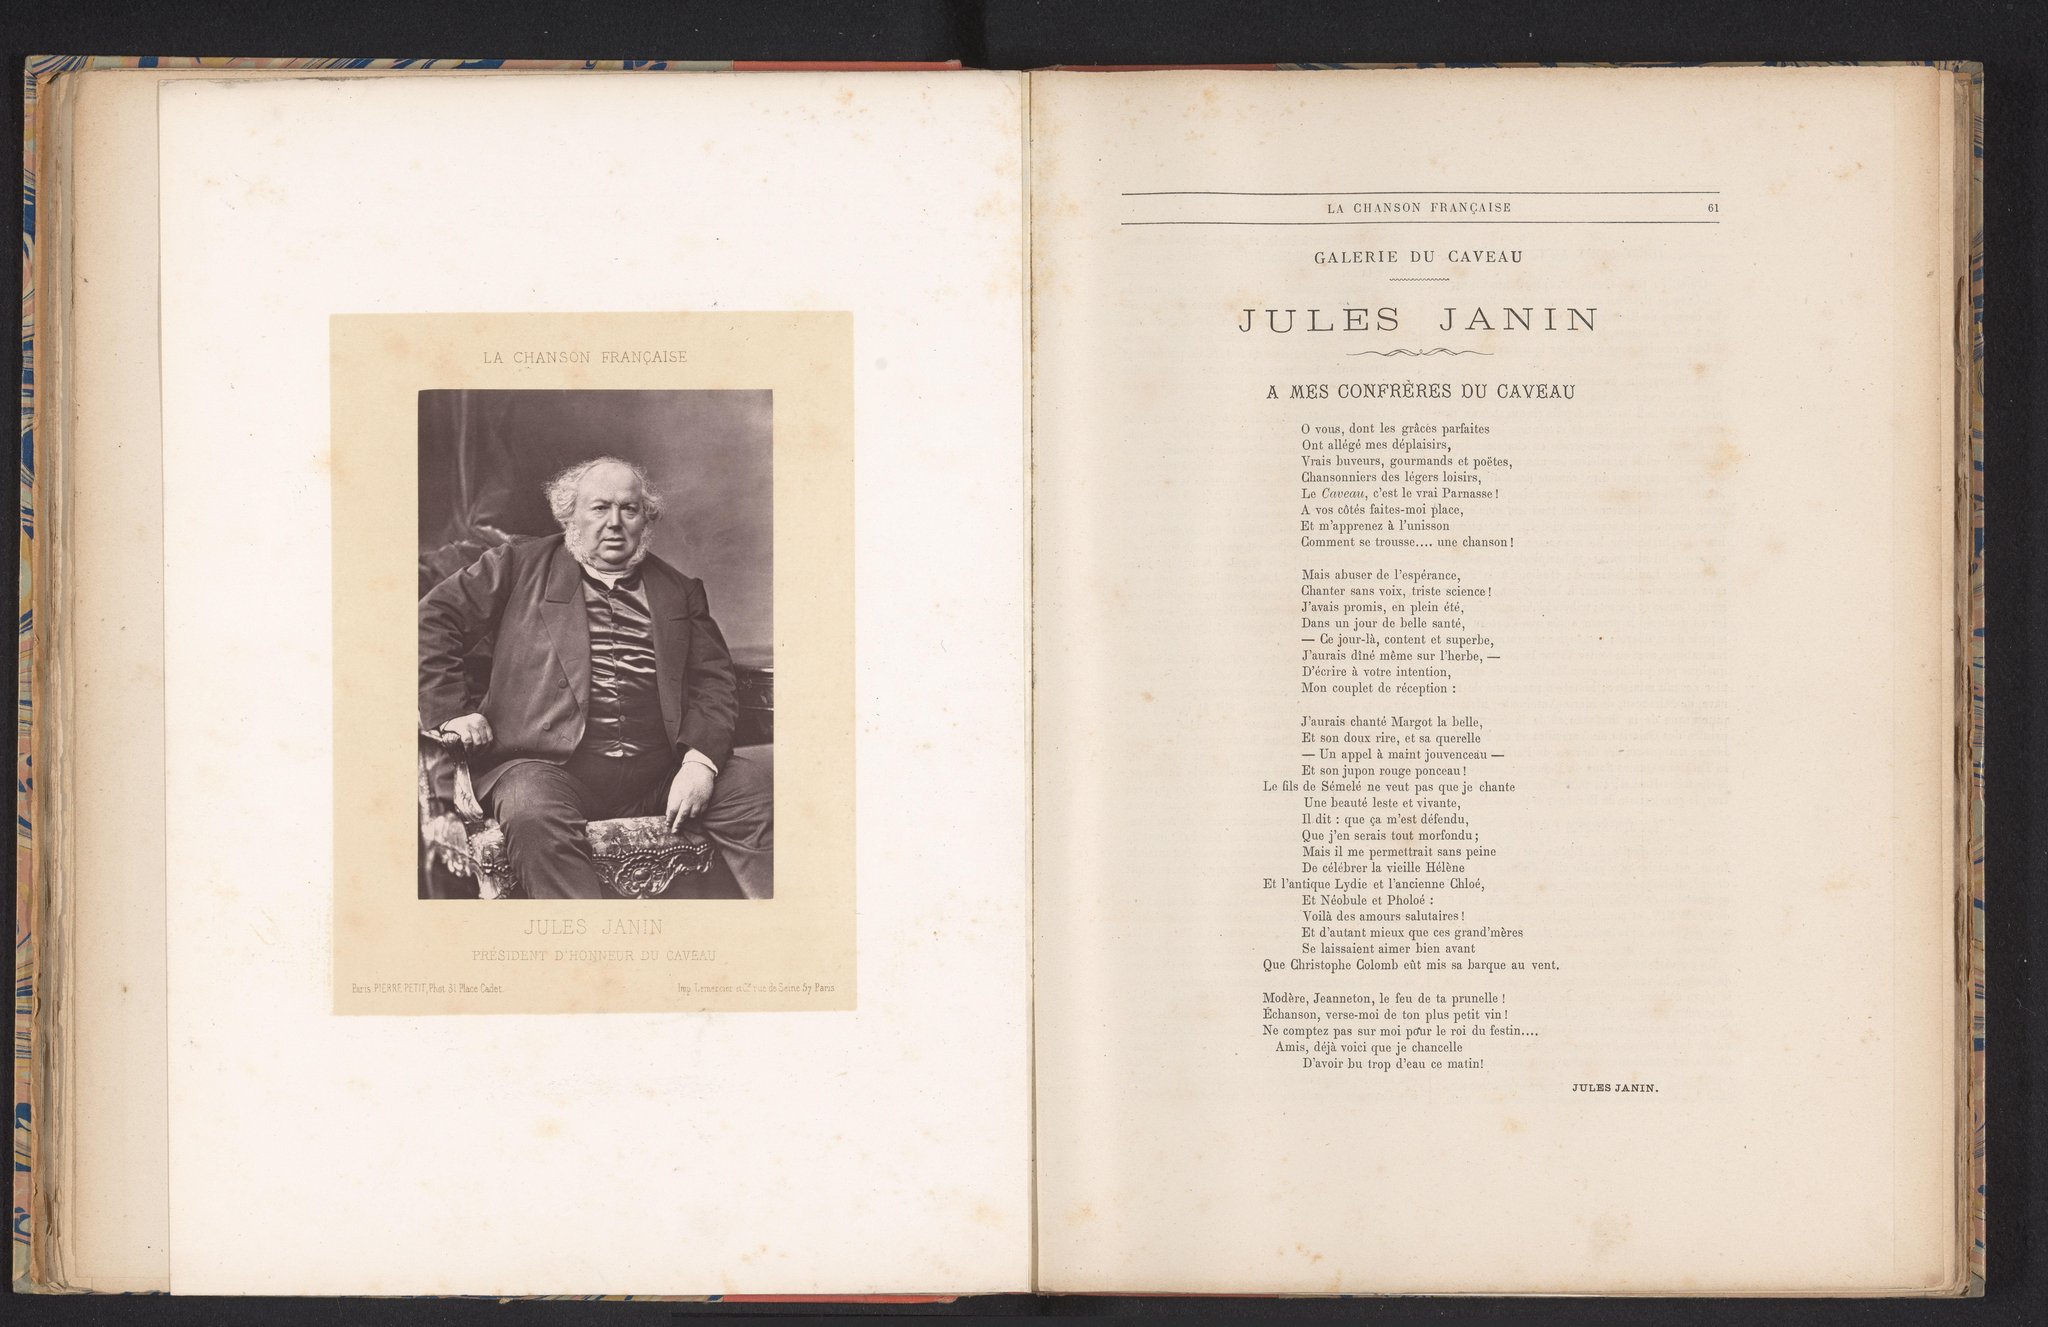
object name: page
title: Portret van Jules Gabriel Janin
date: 1866-1876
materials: paper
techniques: woodburytype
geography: paris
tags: jules gabriel janin, portrait of a writer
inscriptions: name: ‘Paris Pierre Petit Phot. 31, Place Cadet Imp. Lemercier et Cie rue de Seine 57 Paris’, inscription: ‘La Chanson Française’